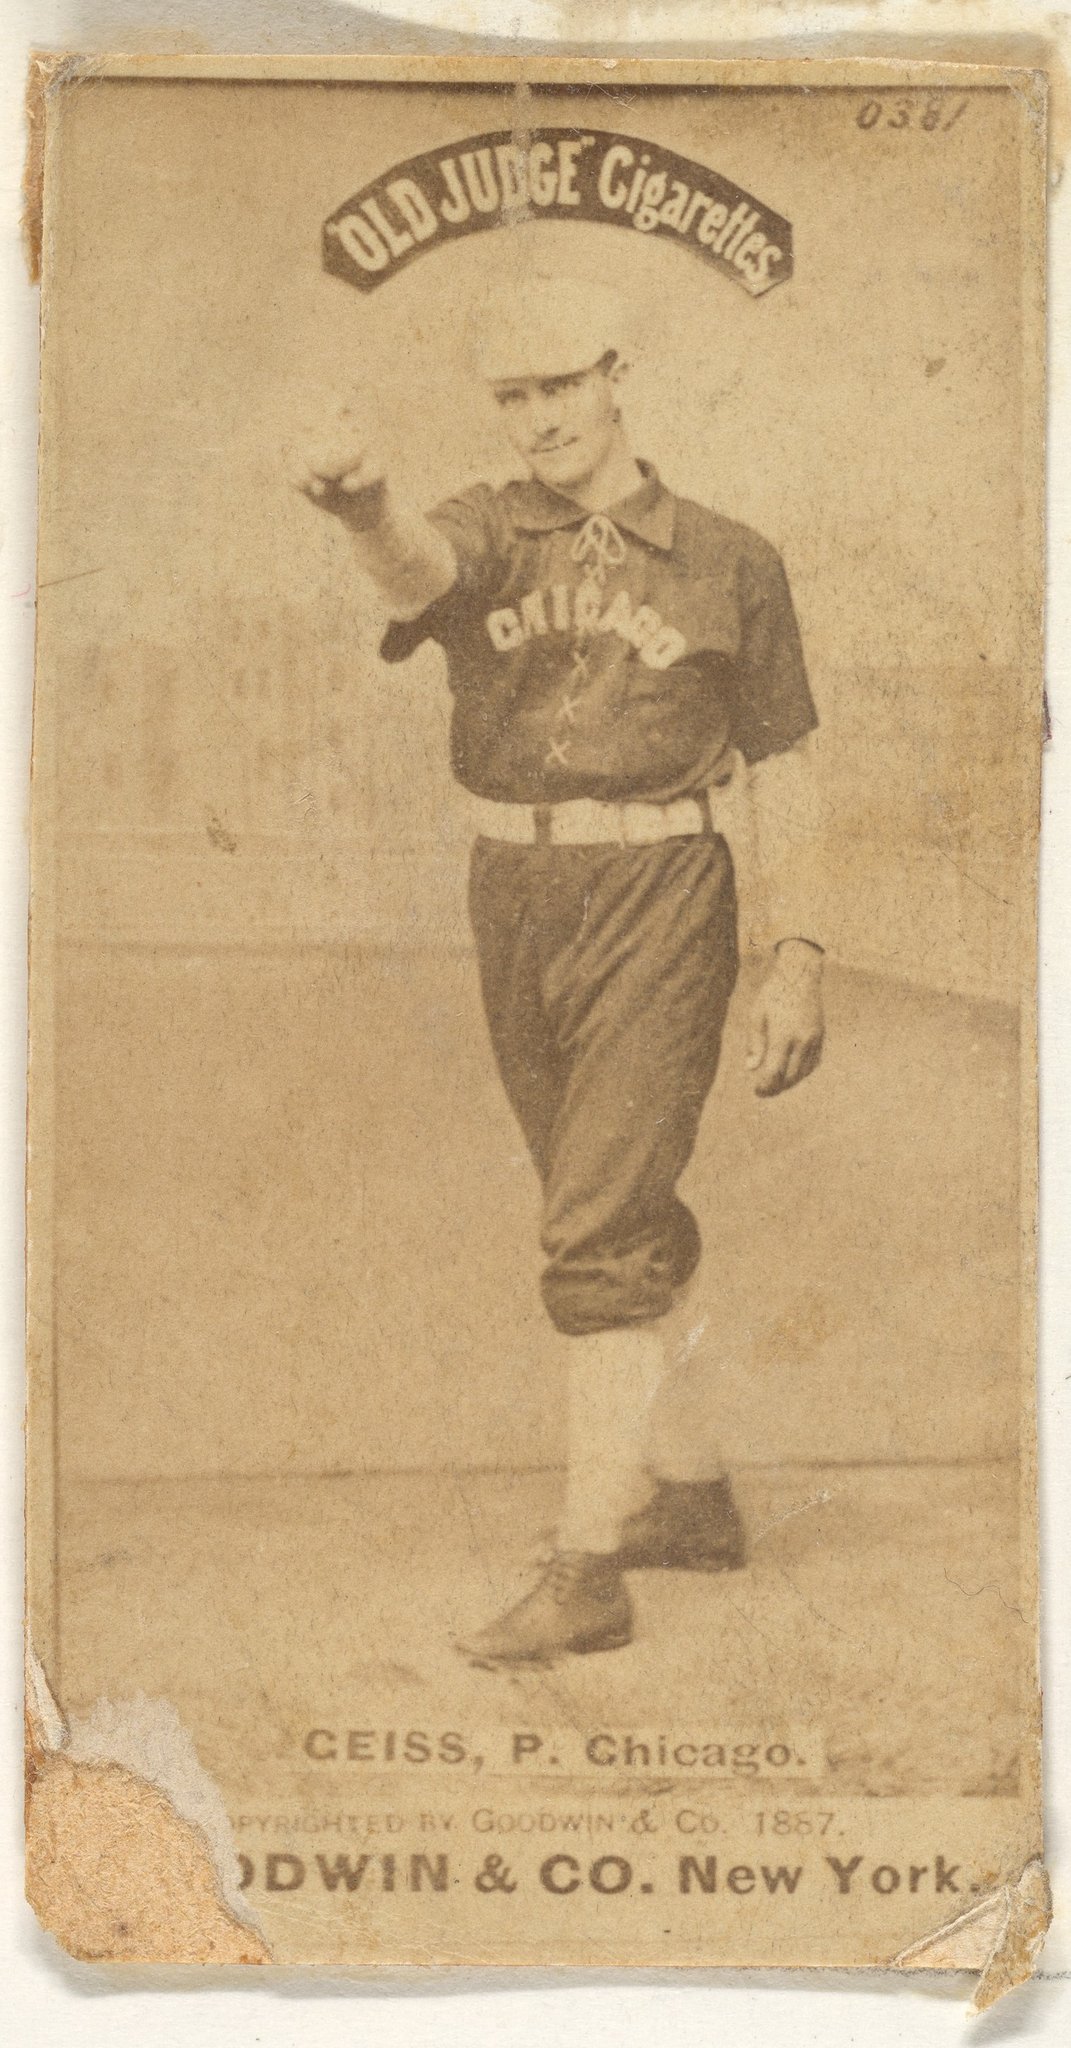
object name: baseball card, photograph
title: Geiss, Pitcher, Chicago, from the Old Judge series (N172) for Old Judge Cigarettes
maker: goodwin & company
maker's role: publisher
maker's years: 1850-1950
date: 1887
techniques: albumen silver print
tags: men,portraits,baseball,athletes